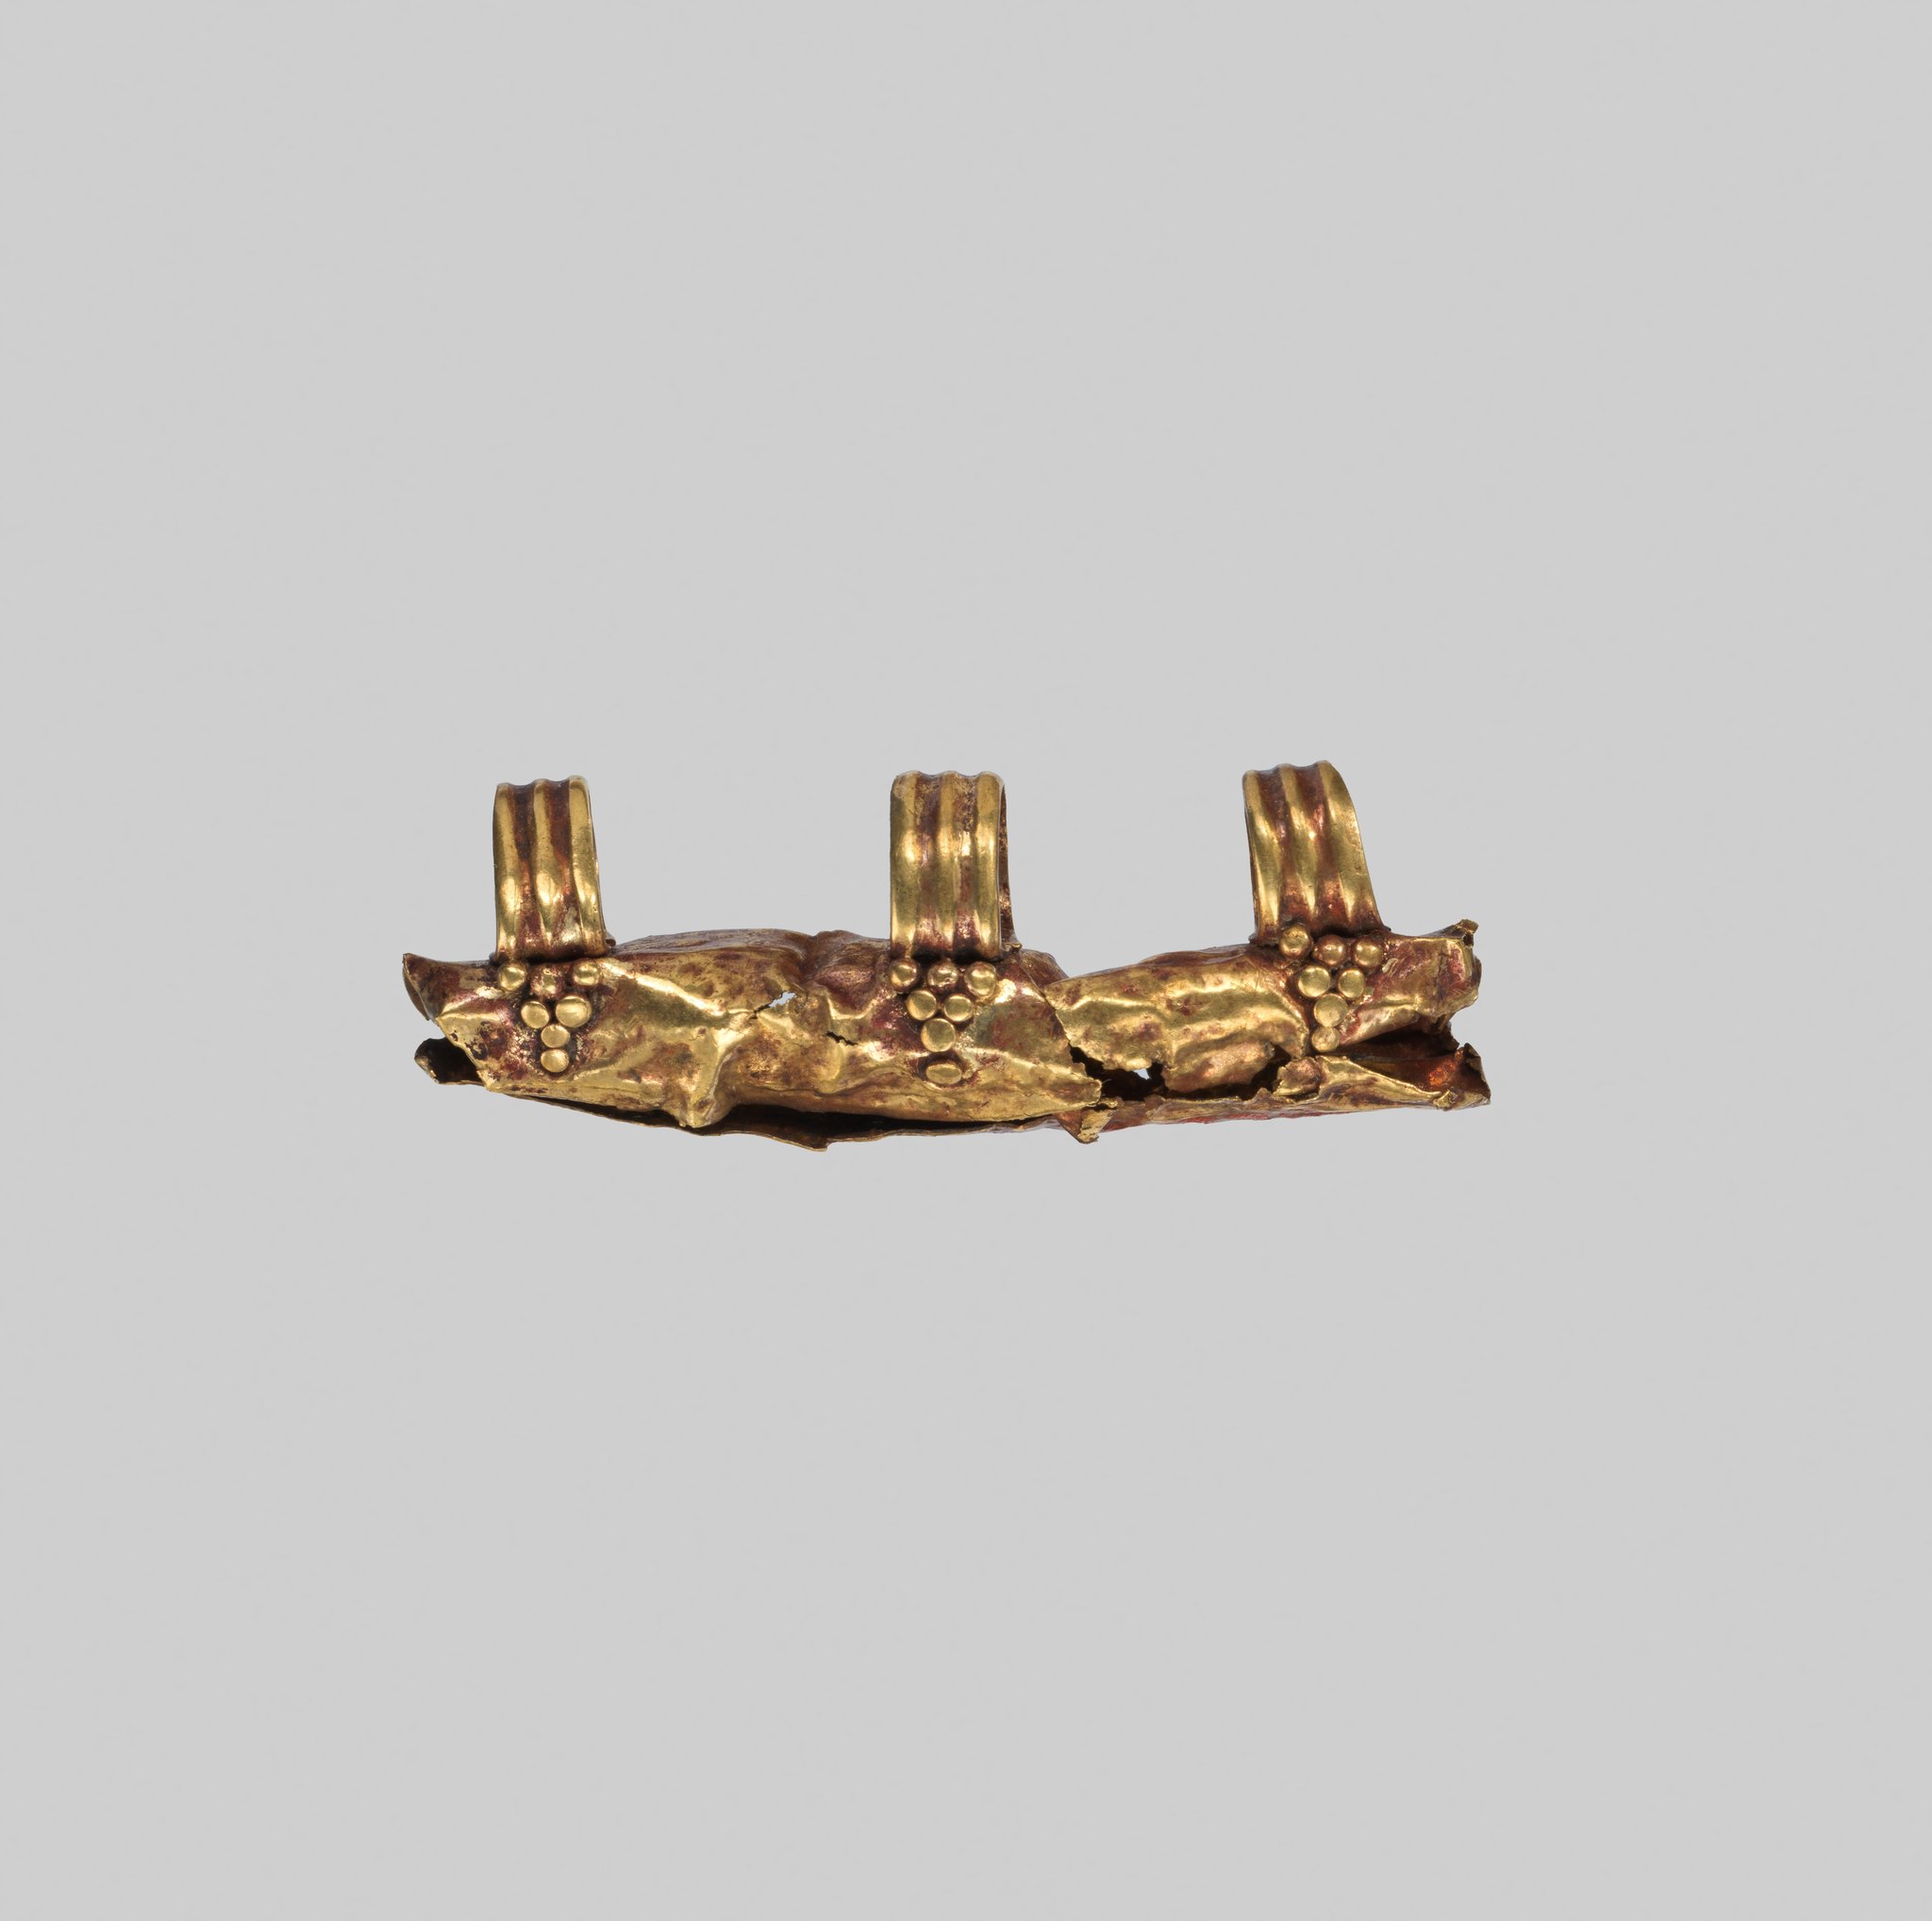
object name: amulet case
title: Gold amulet case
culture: roman, cypriot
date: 1-300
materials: gold